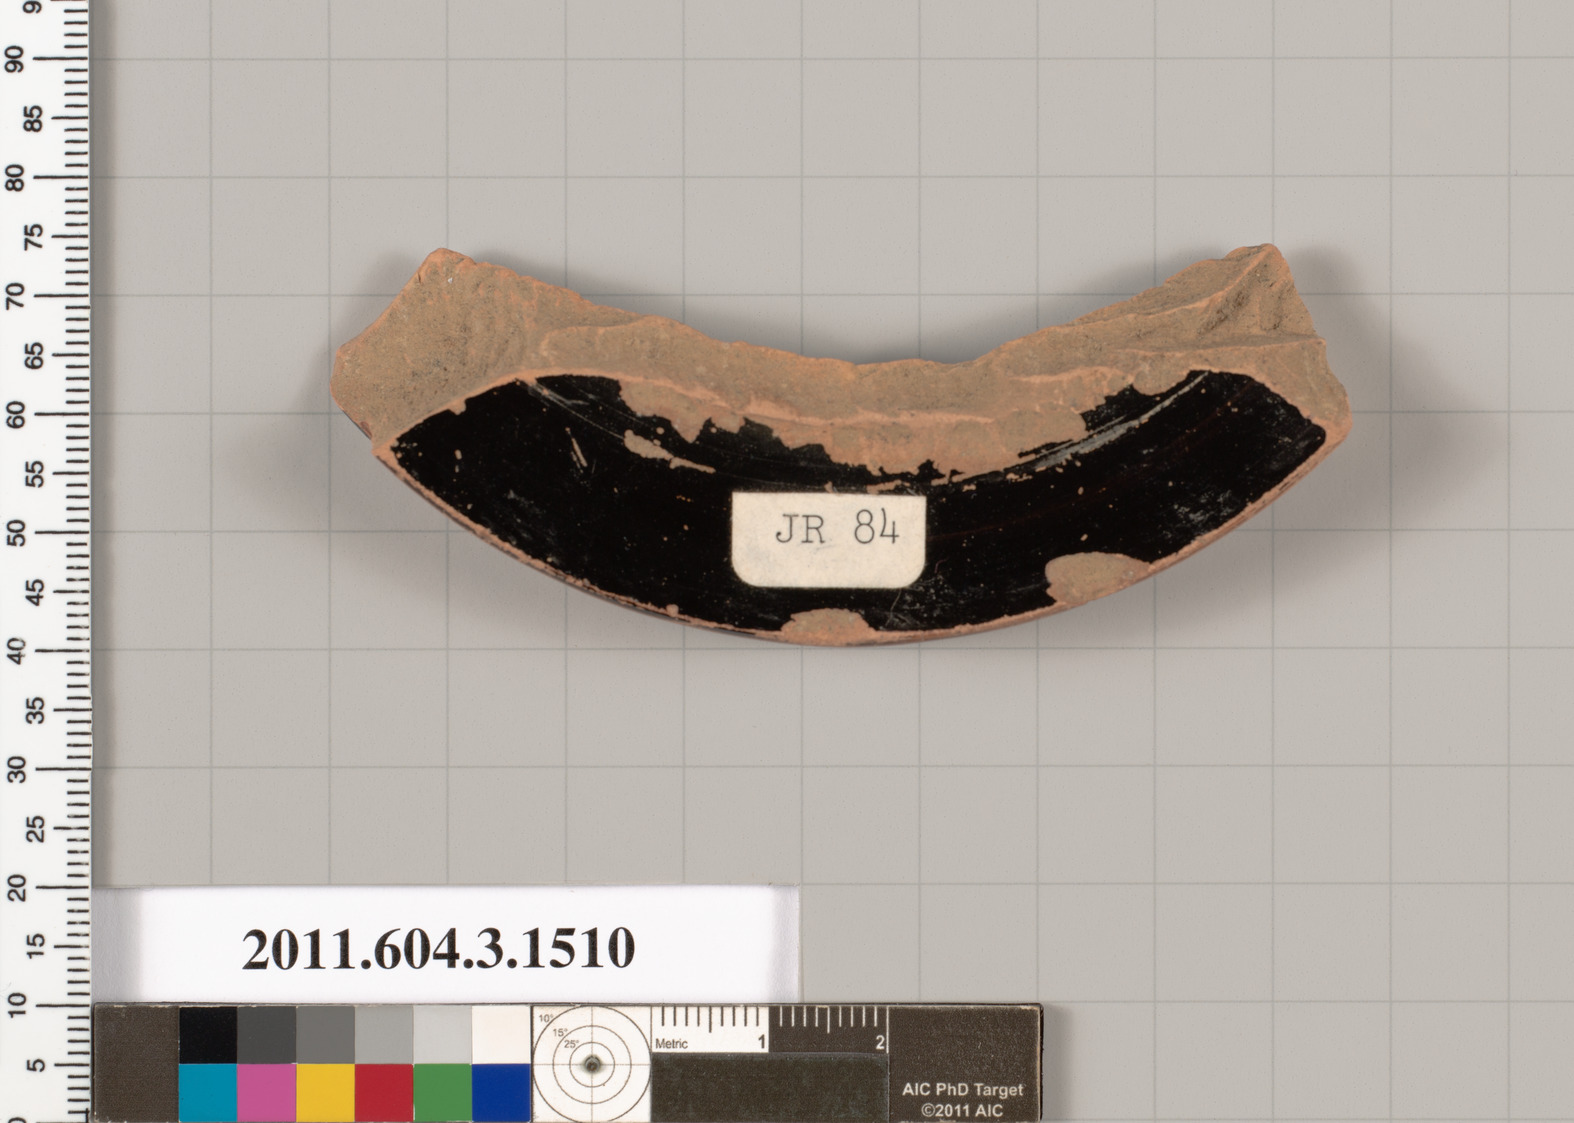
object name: skyphos fragment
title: Terracotta fragment of a skyphos (deep drinking cup)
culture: greek, attic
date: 600-401 BCE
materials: terracotta